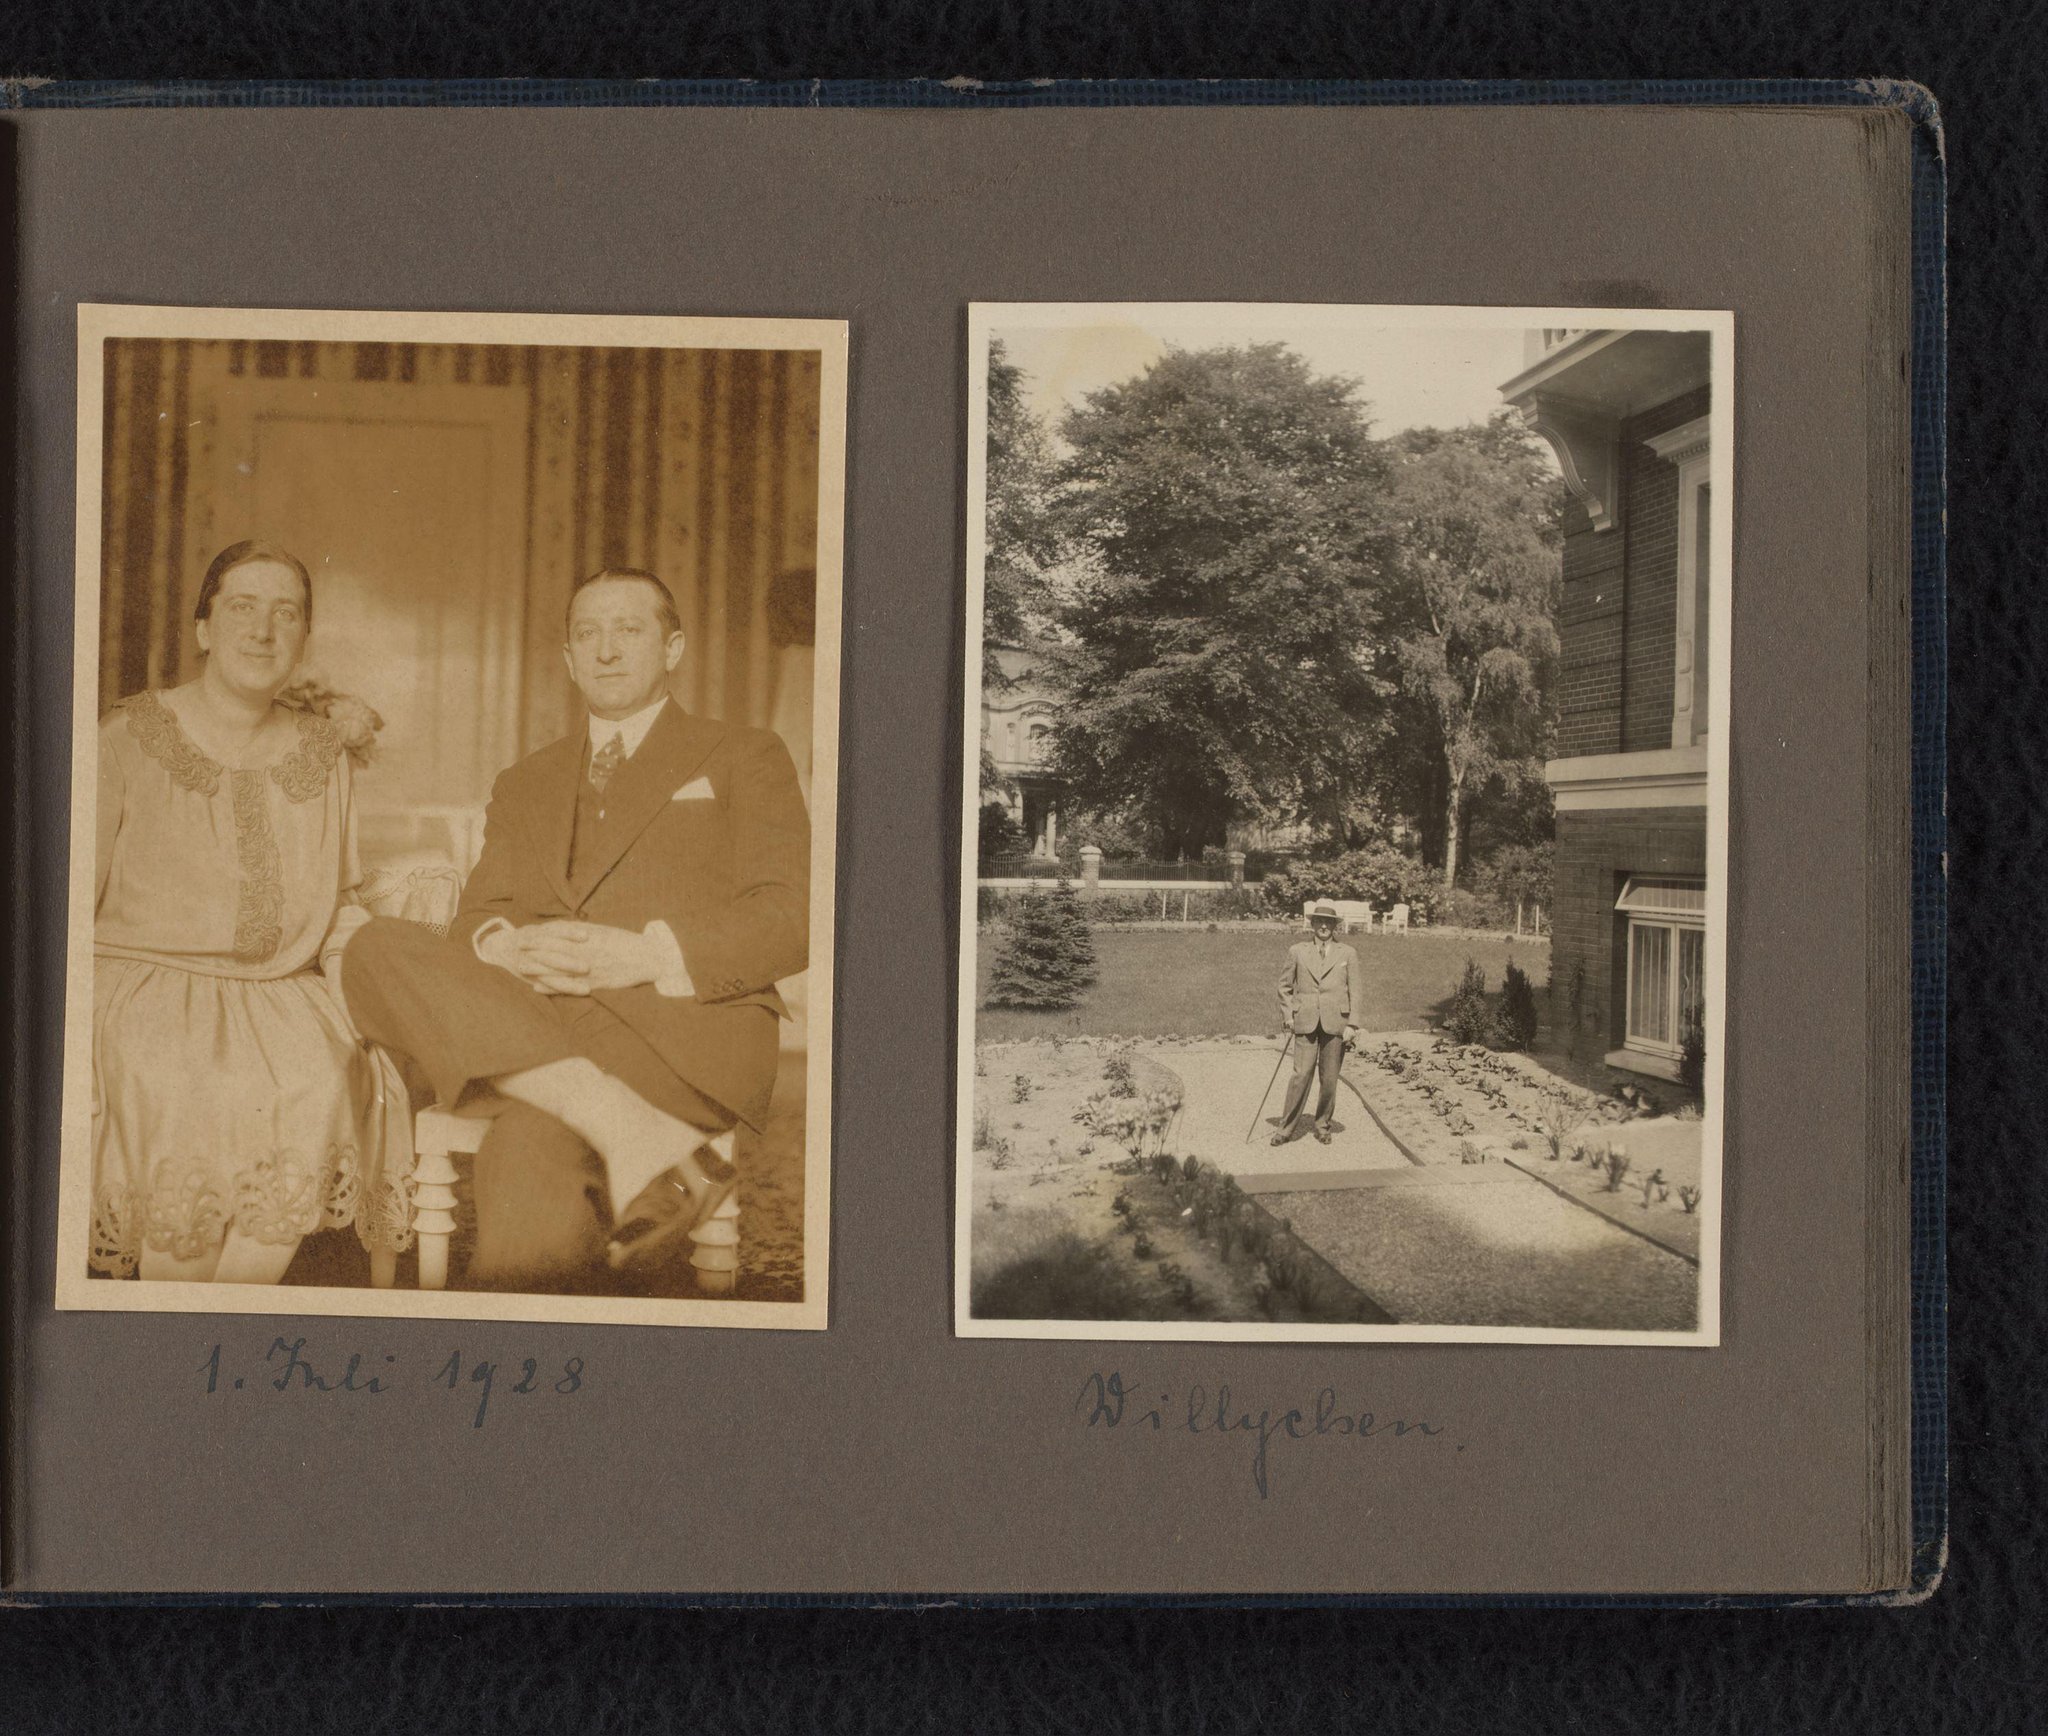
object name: album leaf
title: Willy Moos poseert voor een onbekend gebouw, en samen met zijn zus Else Wachenheimer-Moos binnen een gebouw, een juli 1928, Hamburg of Neurenberg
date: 1928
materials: paper, photographic support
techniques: gelatin silver print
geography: germany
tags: else wachenheimer-moos, willy moos, family life at home, germany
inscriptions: inscription: ‘1. Juli 1928 / Willychen’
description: Albumblad bevat twee foto's van Willy Moos en Else Wachenheimer-Moos. Uit album half formaat, blauw kunstlederen omslag met koordbinding.